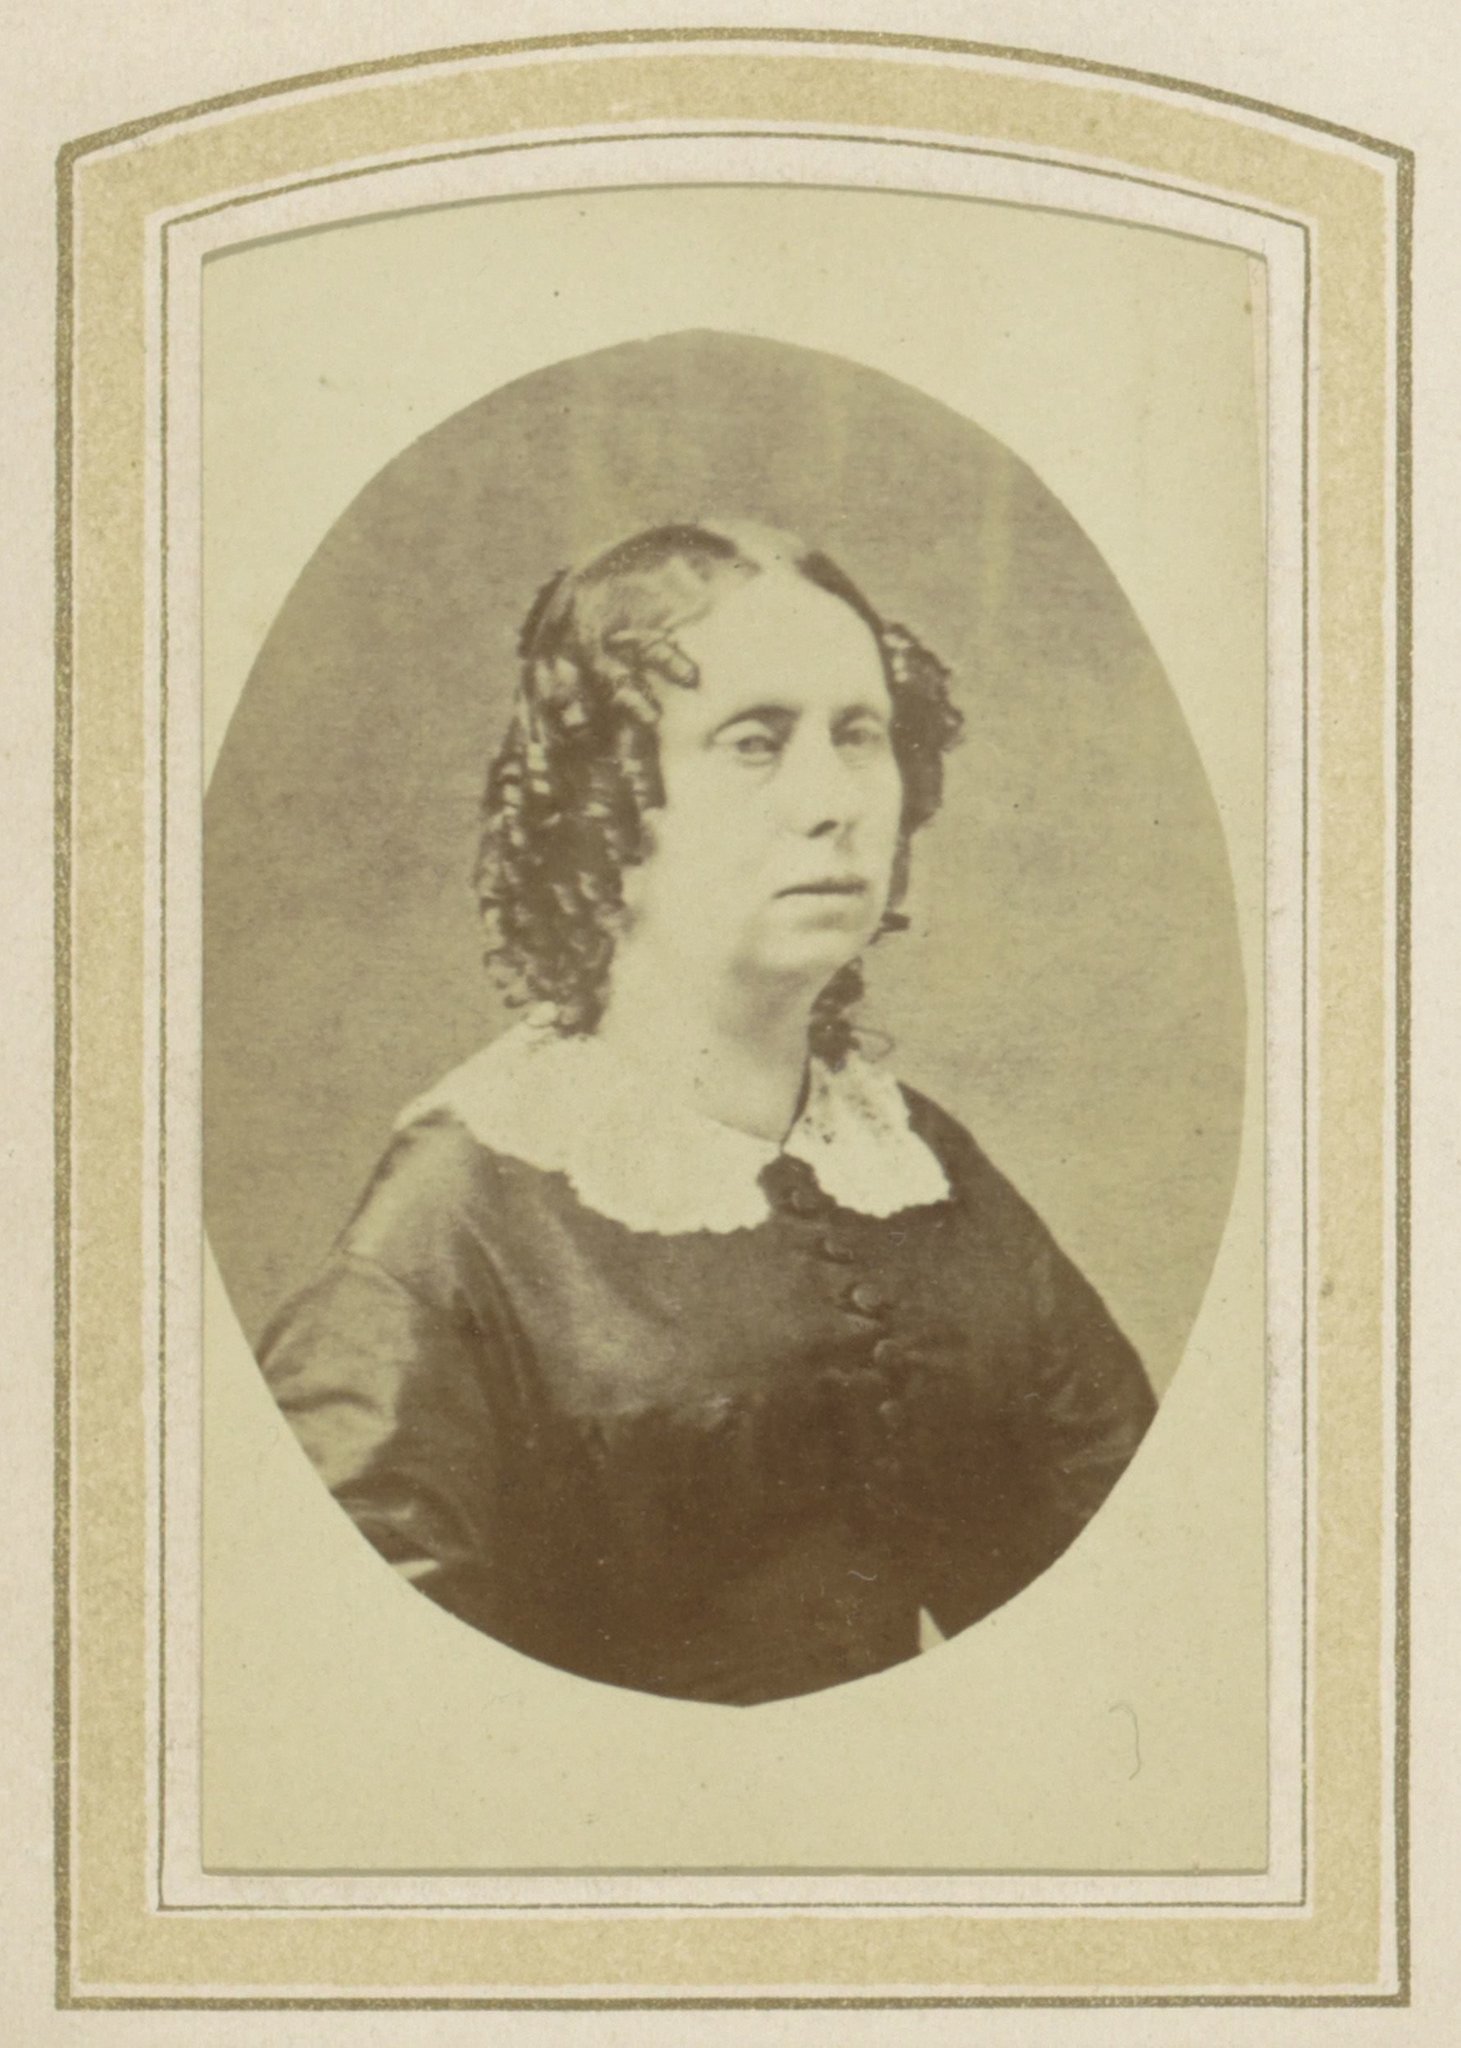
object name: photograph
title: Portret van Sophia Frederika Mathilda van Württemberg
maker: Anonymous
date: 1860-1900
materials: cardboard, paper, photographic support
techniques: albumen print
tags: the hague, sophia frederika mathilda van württemberg, other persons of royal blood, historical persons, styles of hairdress - aa - ~ women, neck-gear ~ clothing, clothing for the upper part of the body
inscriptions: name: ‘Sophie Frédérique Mathilde, Koningin der Nederlanden’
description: Onderdeel van Fotoalbum van een Nederlandse familie met 168 cartes-de-visite en kabinetfoto's.